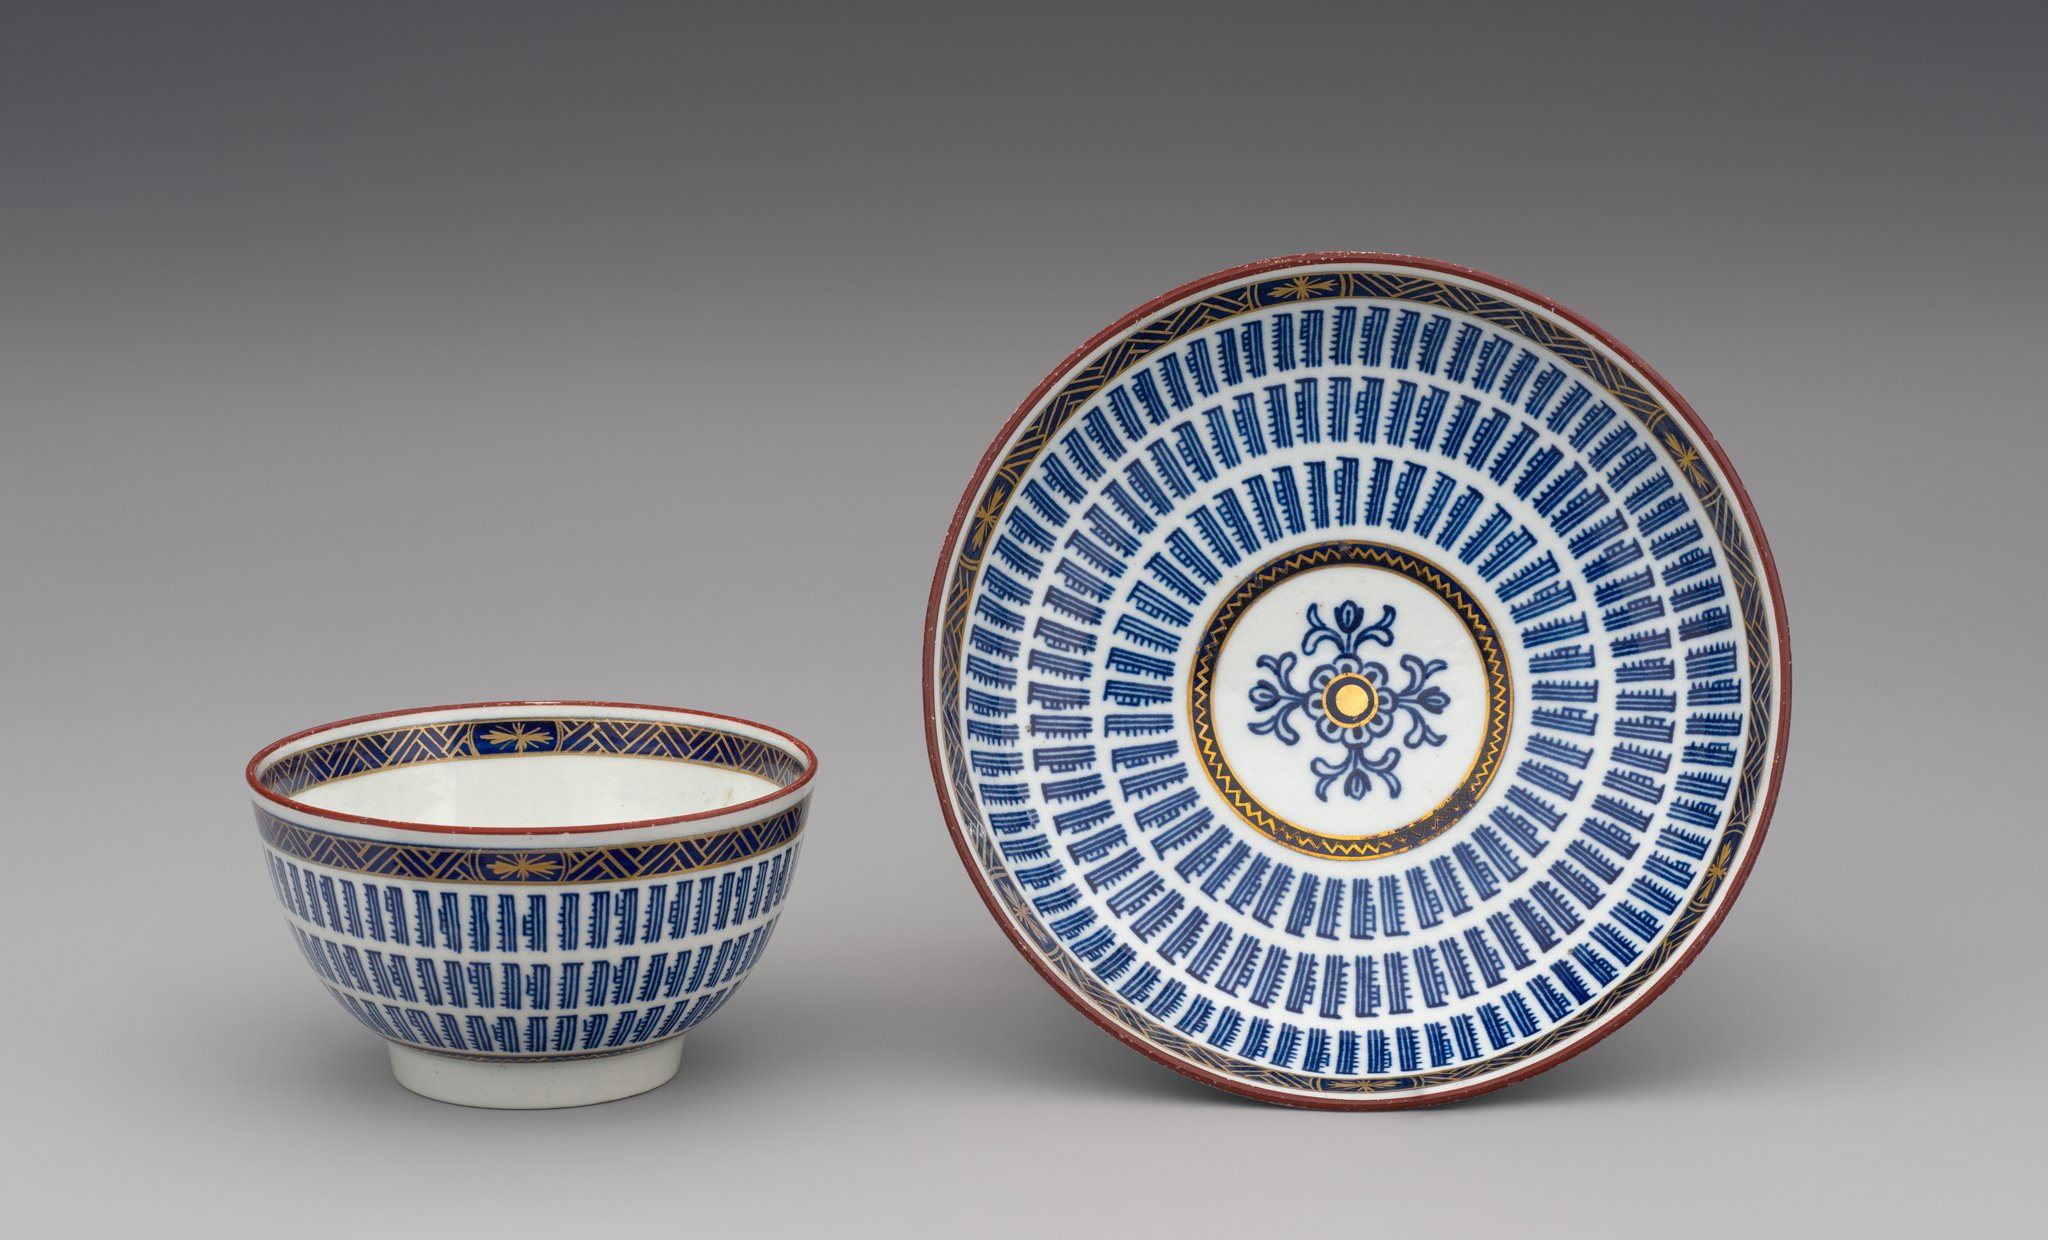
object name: cup and saucer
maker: worcester factory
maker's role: factory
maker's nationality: british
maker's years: 1751-2008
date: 1701-1800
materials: soft paste porcelain